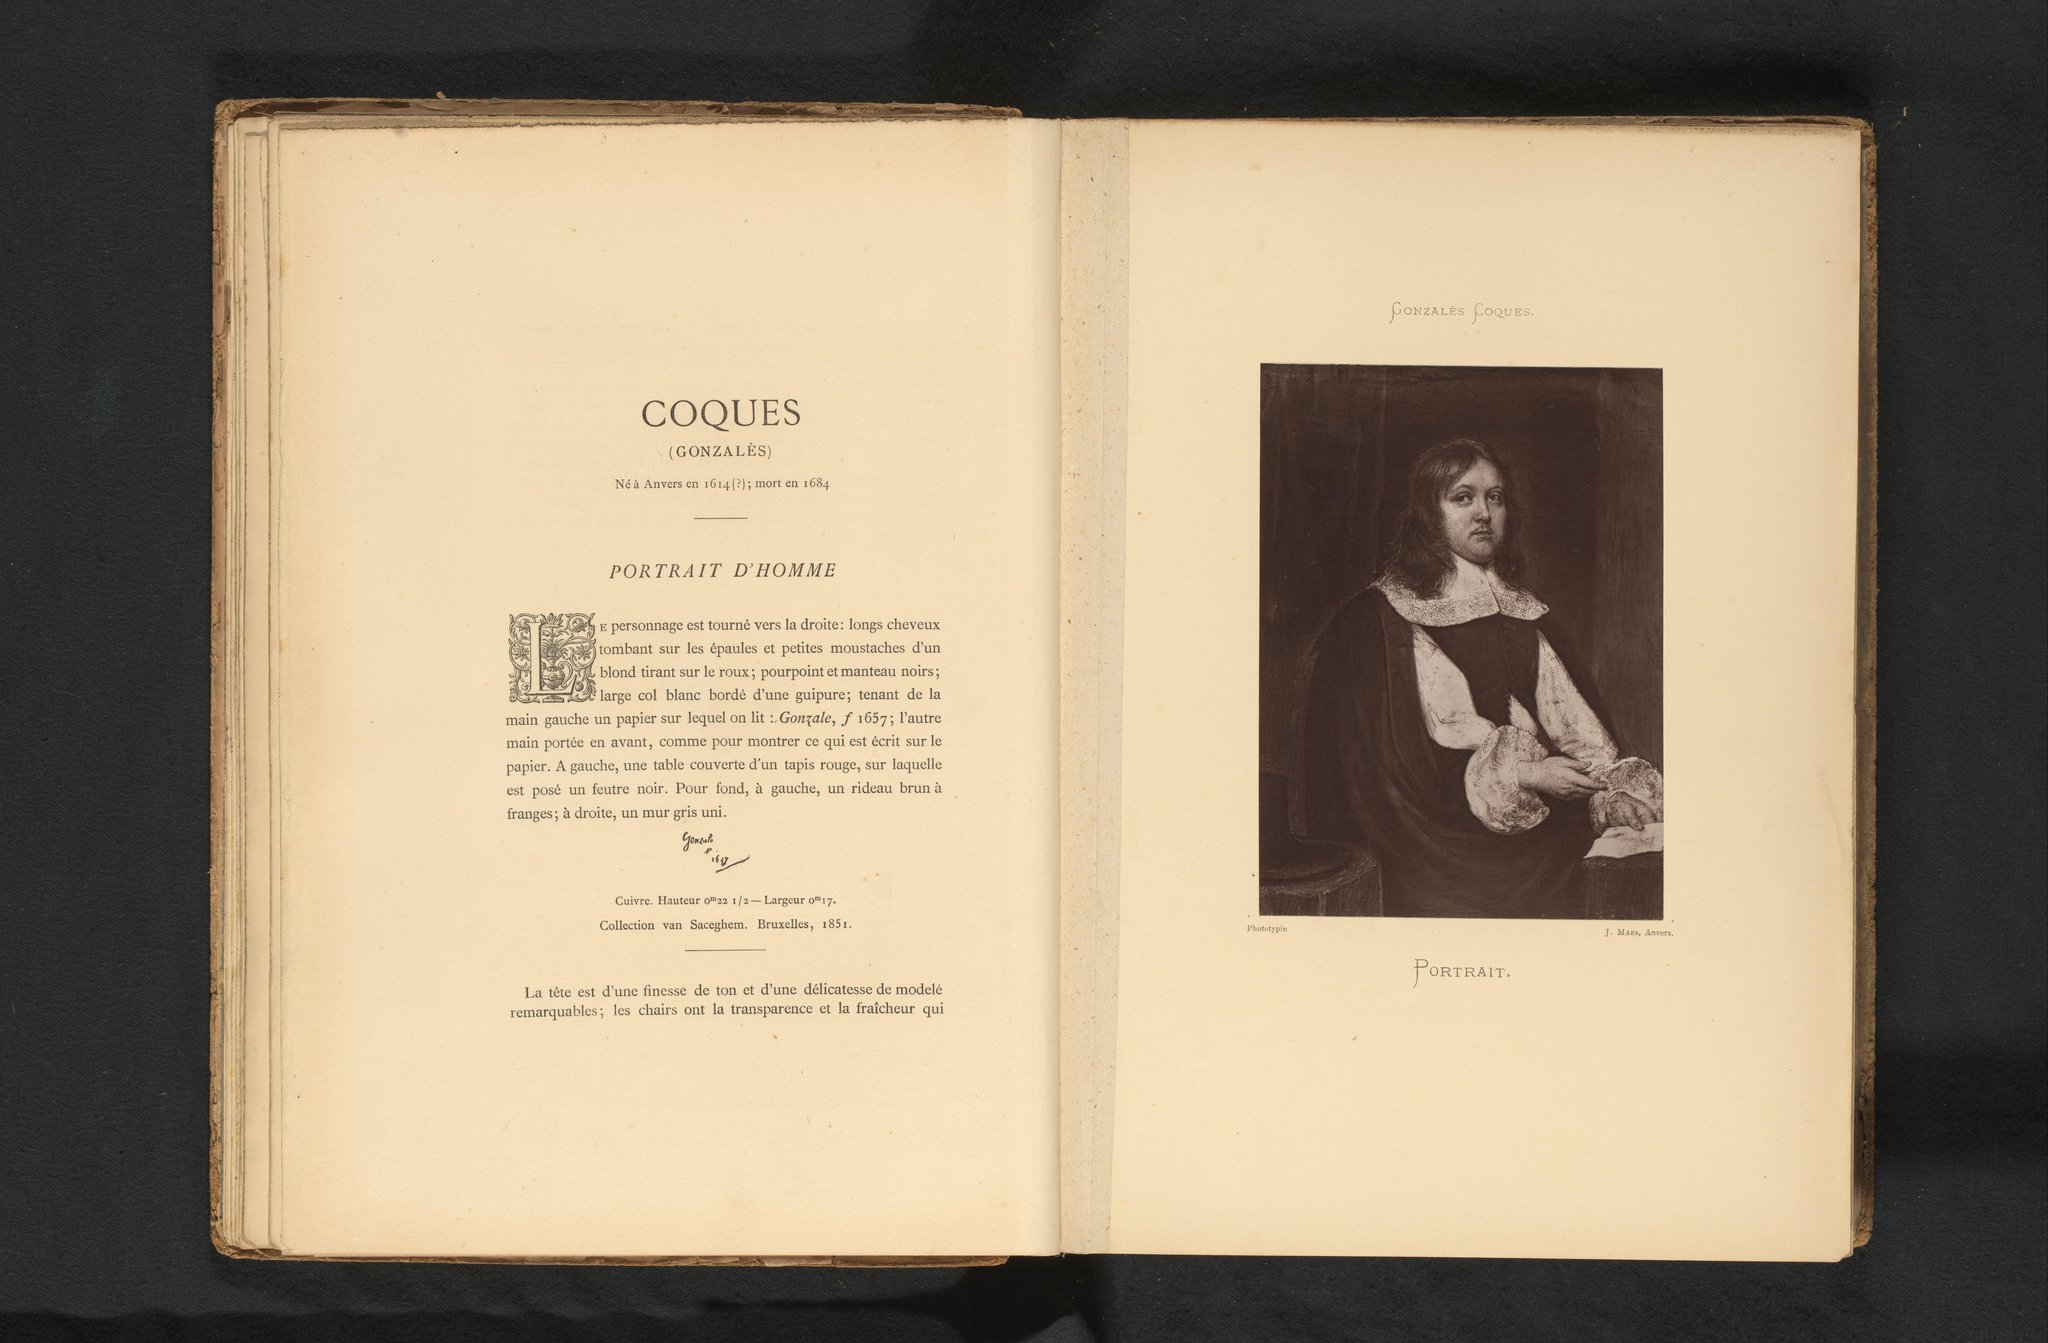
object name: page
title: Reproductie van geschilderd portret van een onbekende man door Gonzales Coques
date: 1873-1878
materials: paper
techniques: woodburytype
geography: antwerp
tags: historical persons